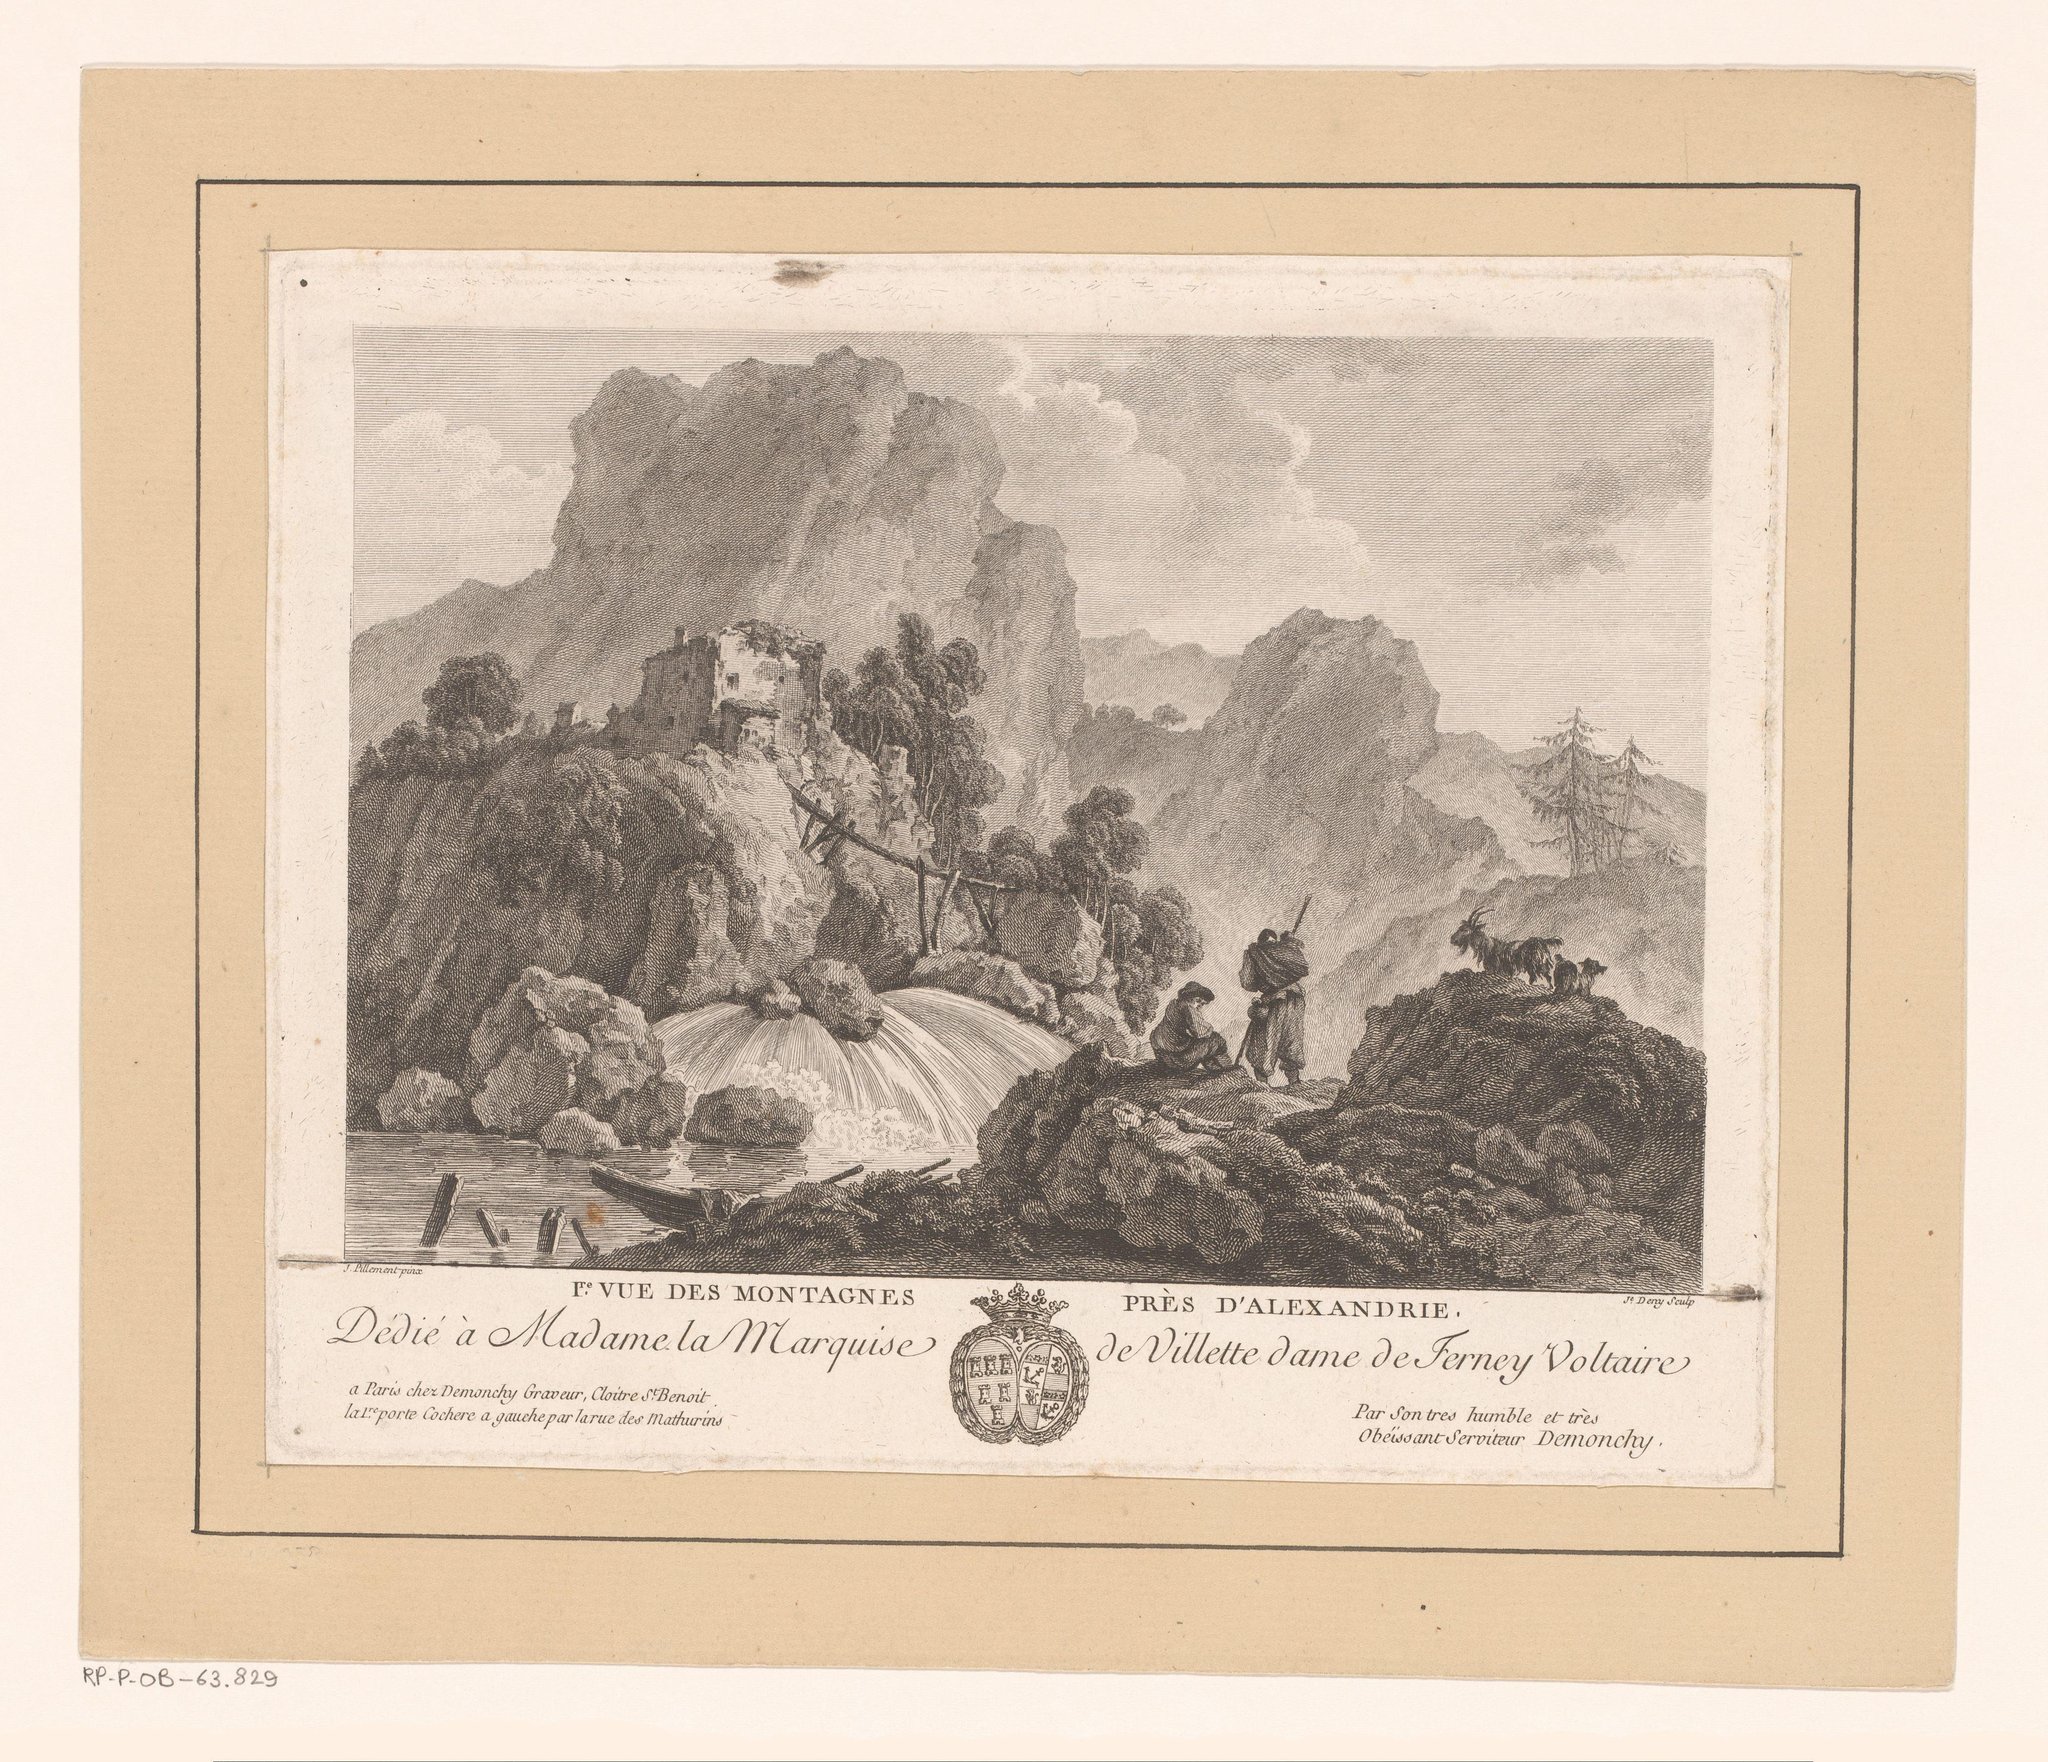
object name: print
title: Gezicht op de bergen bij Alexandrië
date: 1759-1815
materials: paper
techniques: etching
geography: paris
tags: landscapes, waterfall, armorial bearing, heraldry, mountains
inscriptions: collector's mark: Lugt 2228